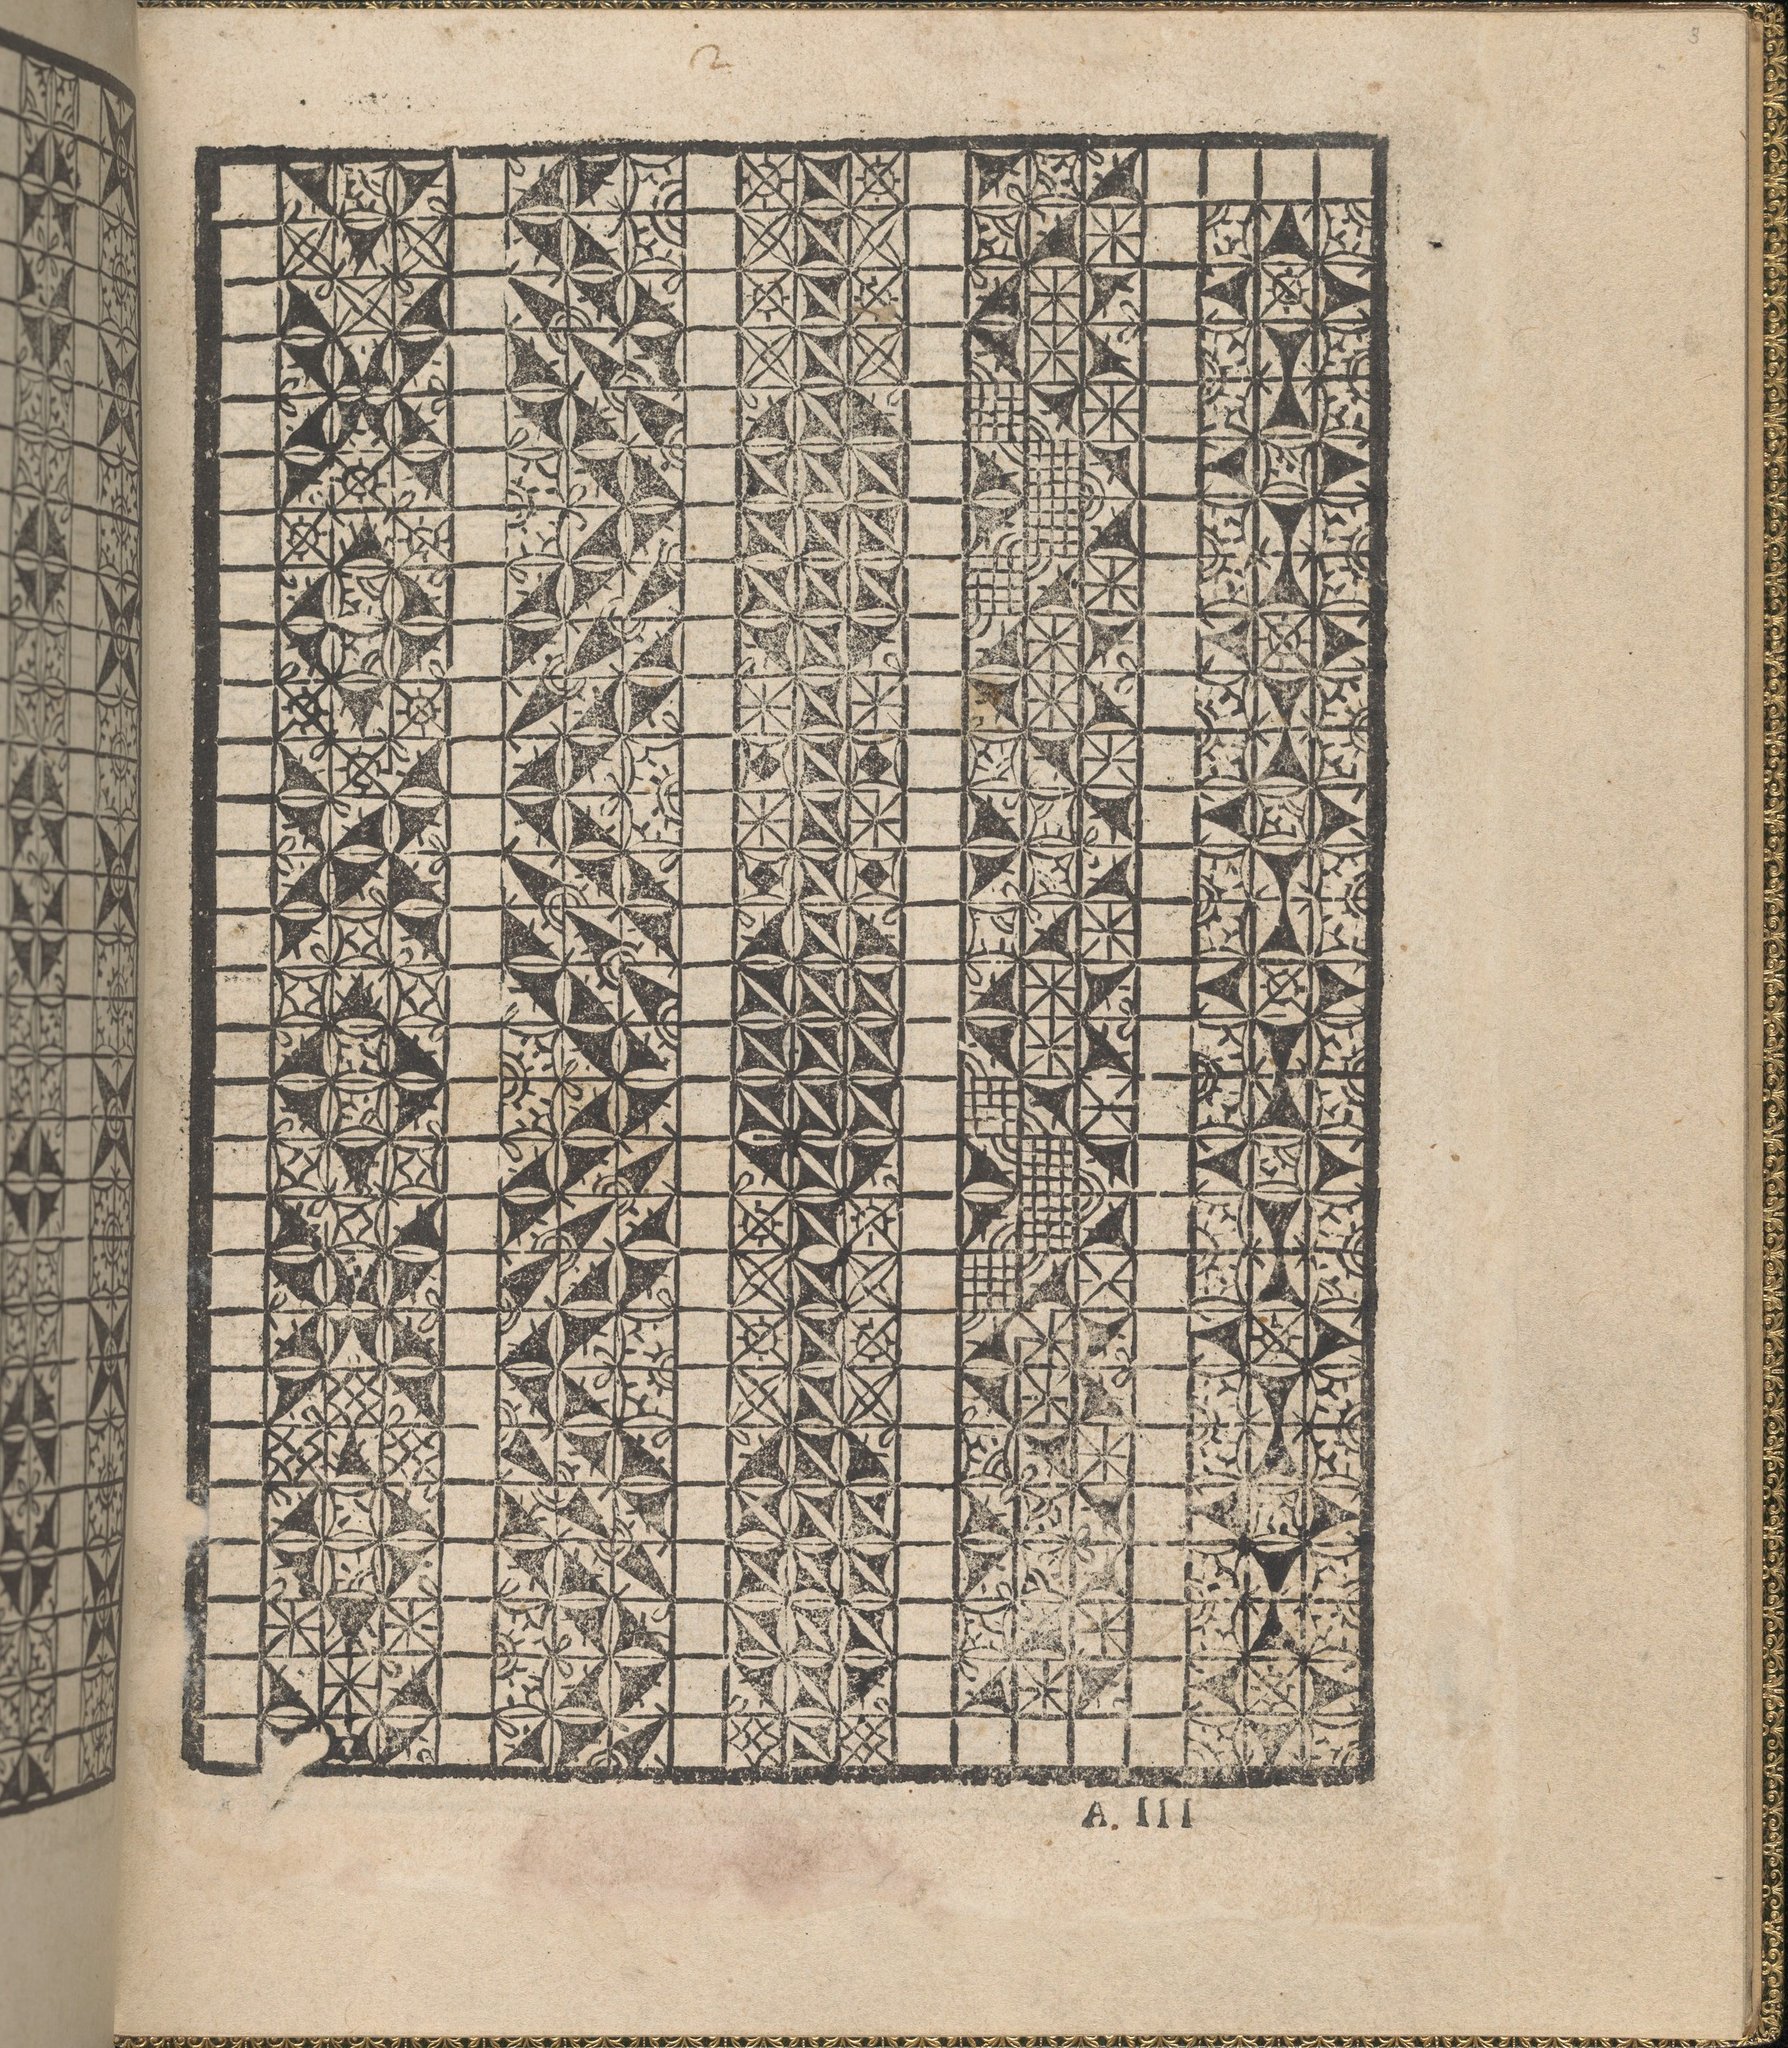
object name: book print ornament architecture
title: Giardineto novo di punti tagliati et gropposi per exercitio & ornamento delle donne (Venice 1554), page 2 (verso)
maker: matteo pagano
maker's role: publisher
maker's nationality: italian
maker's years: 1515-1588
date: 1554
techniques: woodcut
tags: ornament